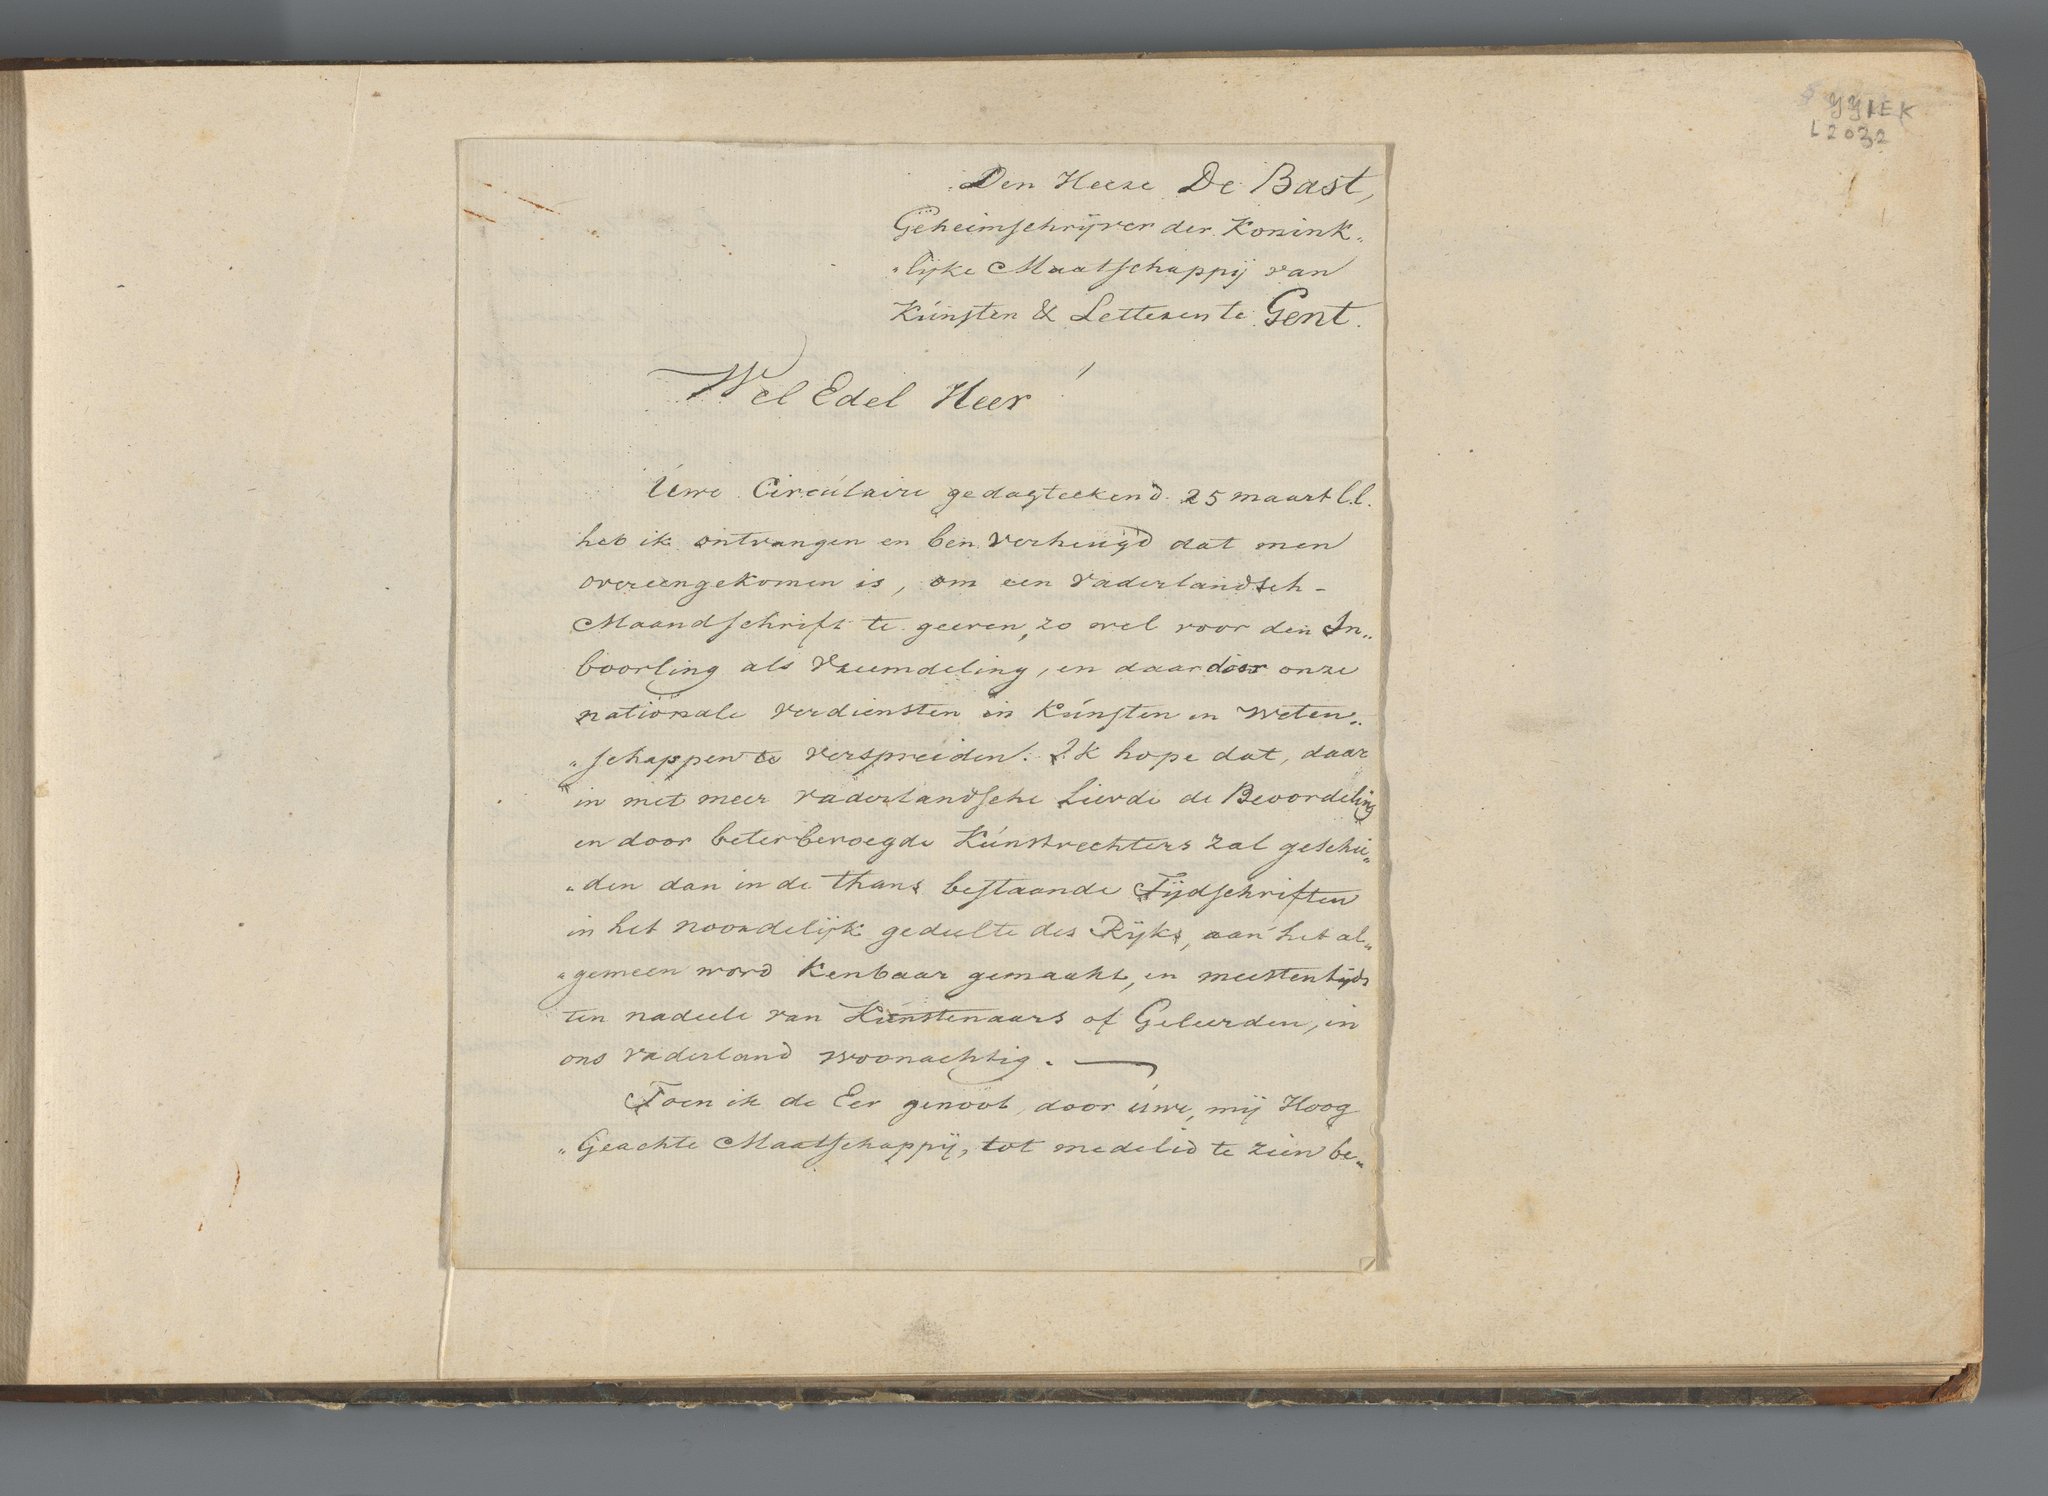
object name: letter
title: Brief van Jacob Ernst Marcus aan de heer De Bast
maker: jacob ernst marcus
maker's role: draughtsman, print maker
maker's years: 1774-1826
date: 1823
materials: ink, paper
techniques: pen, writing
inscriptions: date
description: De brief, gedateerd 19 april 1823 en gericht aan 'Den Heere De Bast/ Geheimschrijver der Konink/-lijke Maatschappij van/ Kunsten & Letteren te Gent', noemt enkele gravures die Marcus aan de Maatschappij gezonden zou hebben zonder daar ooit een reactie op ontvangen te hebben. Vervolgens noemt hij zijn prentenserie 'Studiebeeld en Fragmenten' (zoals in dit album aanwezig), in de hoop dat de Maatschappij deze reeks op wil nemen.